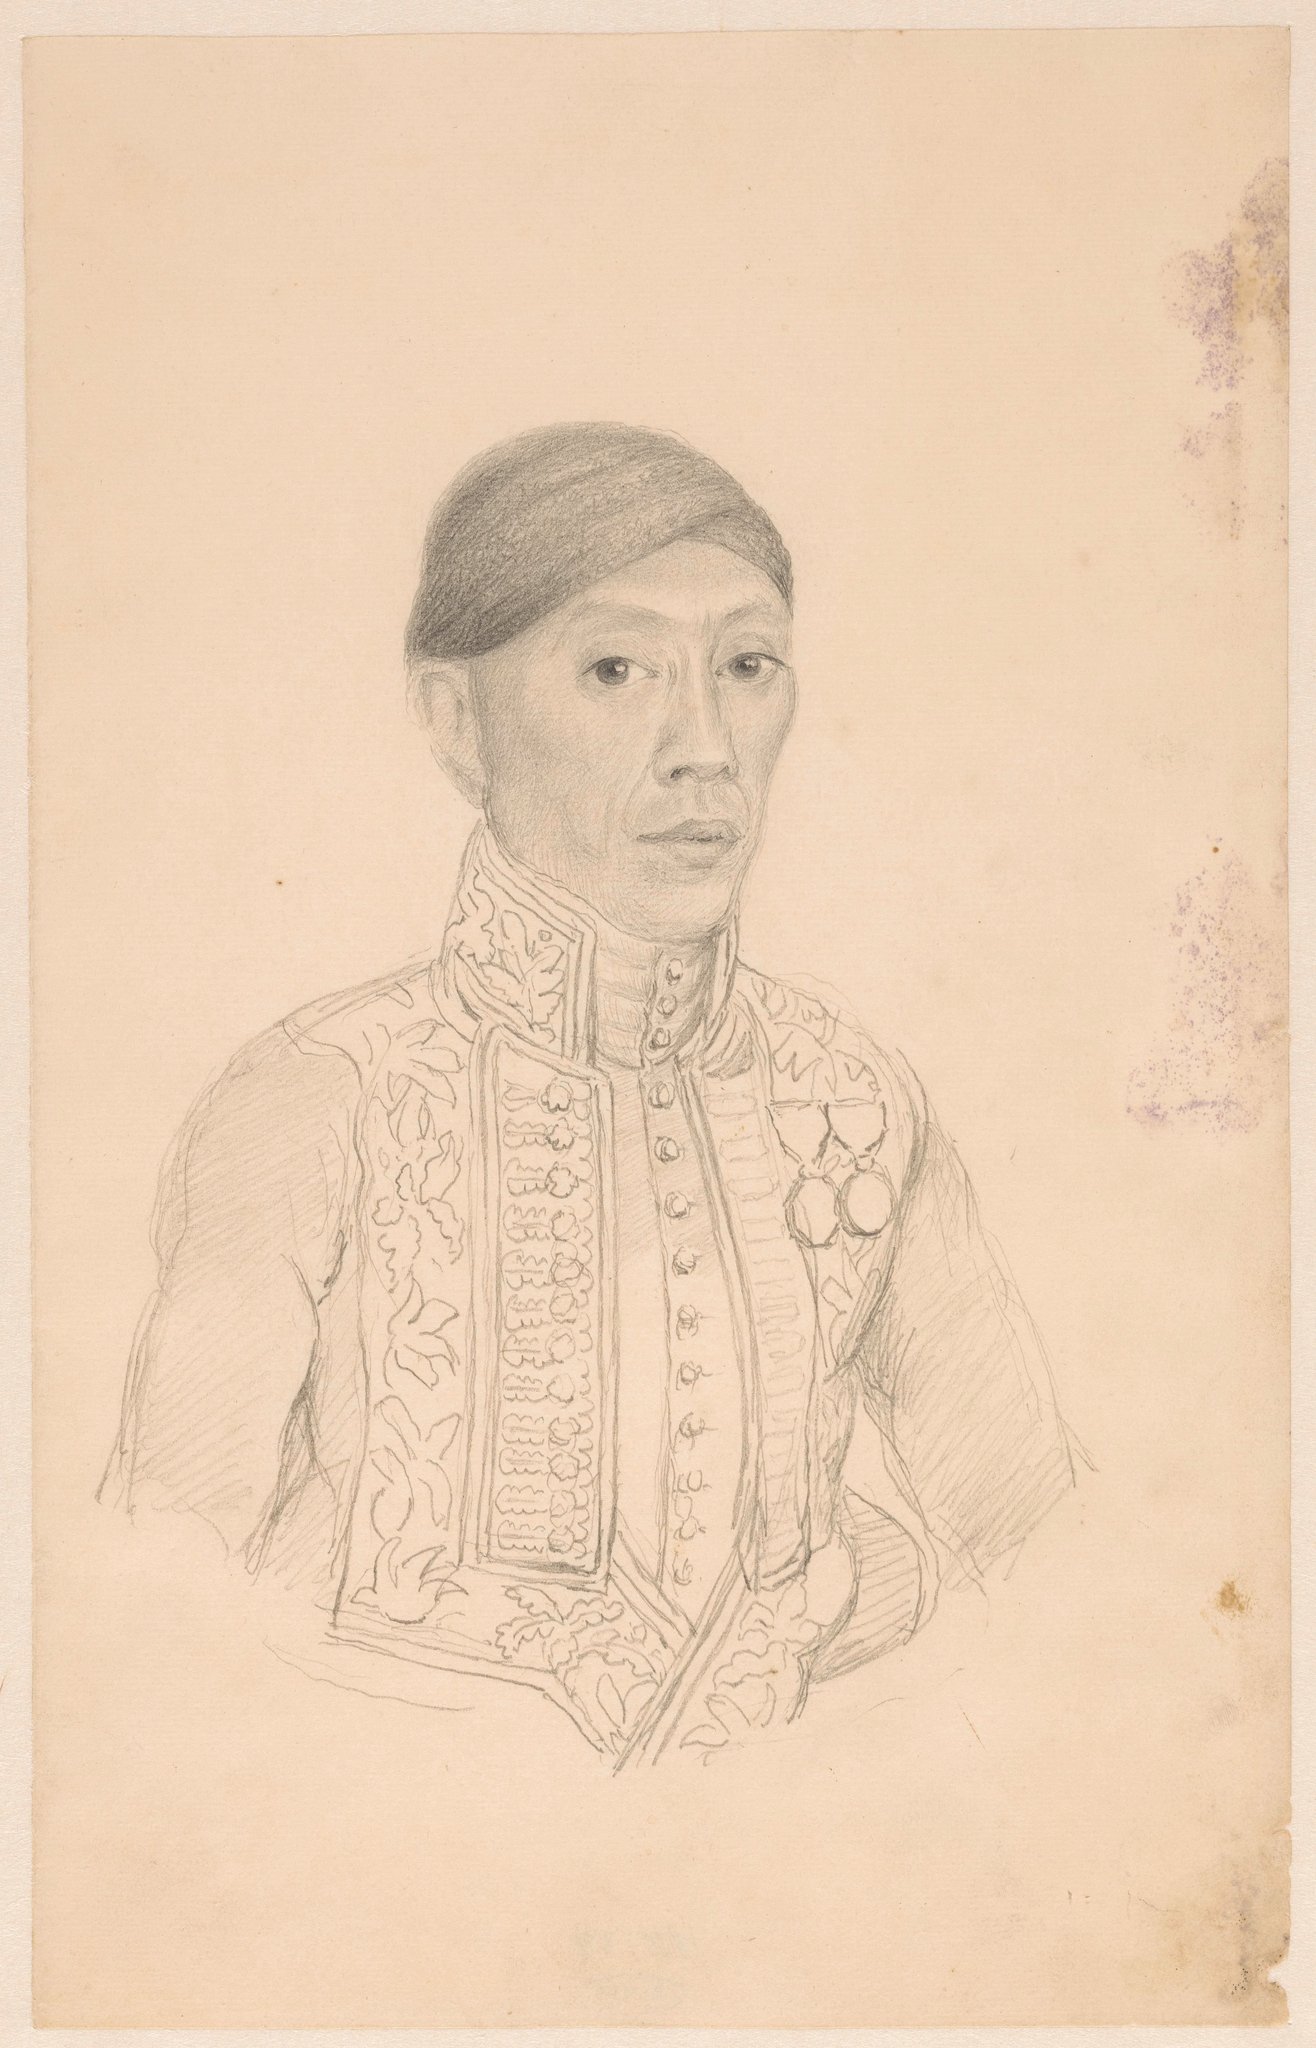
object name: drawing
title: Portret van een Javaanse funcionaris, in een uniform met twee onderscheidingen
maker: christian heinrich gottlieb steuerwald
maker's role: draughtsman, print maker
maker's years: 1802-1874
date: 1848-1854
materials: paper, pencil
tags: asiatic races and peoples (indonesians), anonymous historical person portrayed alone